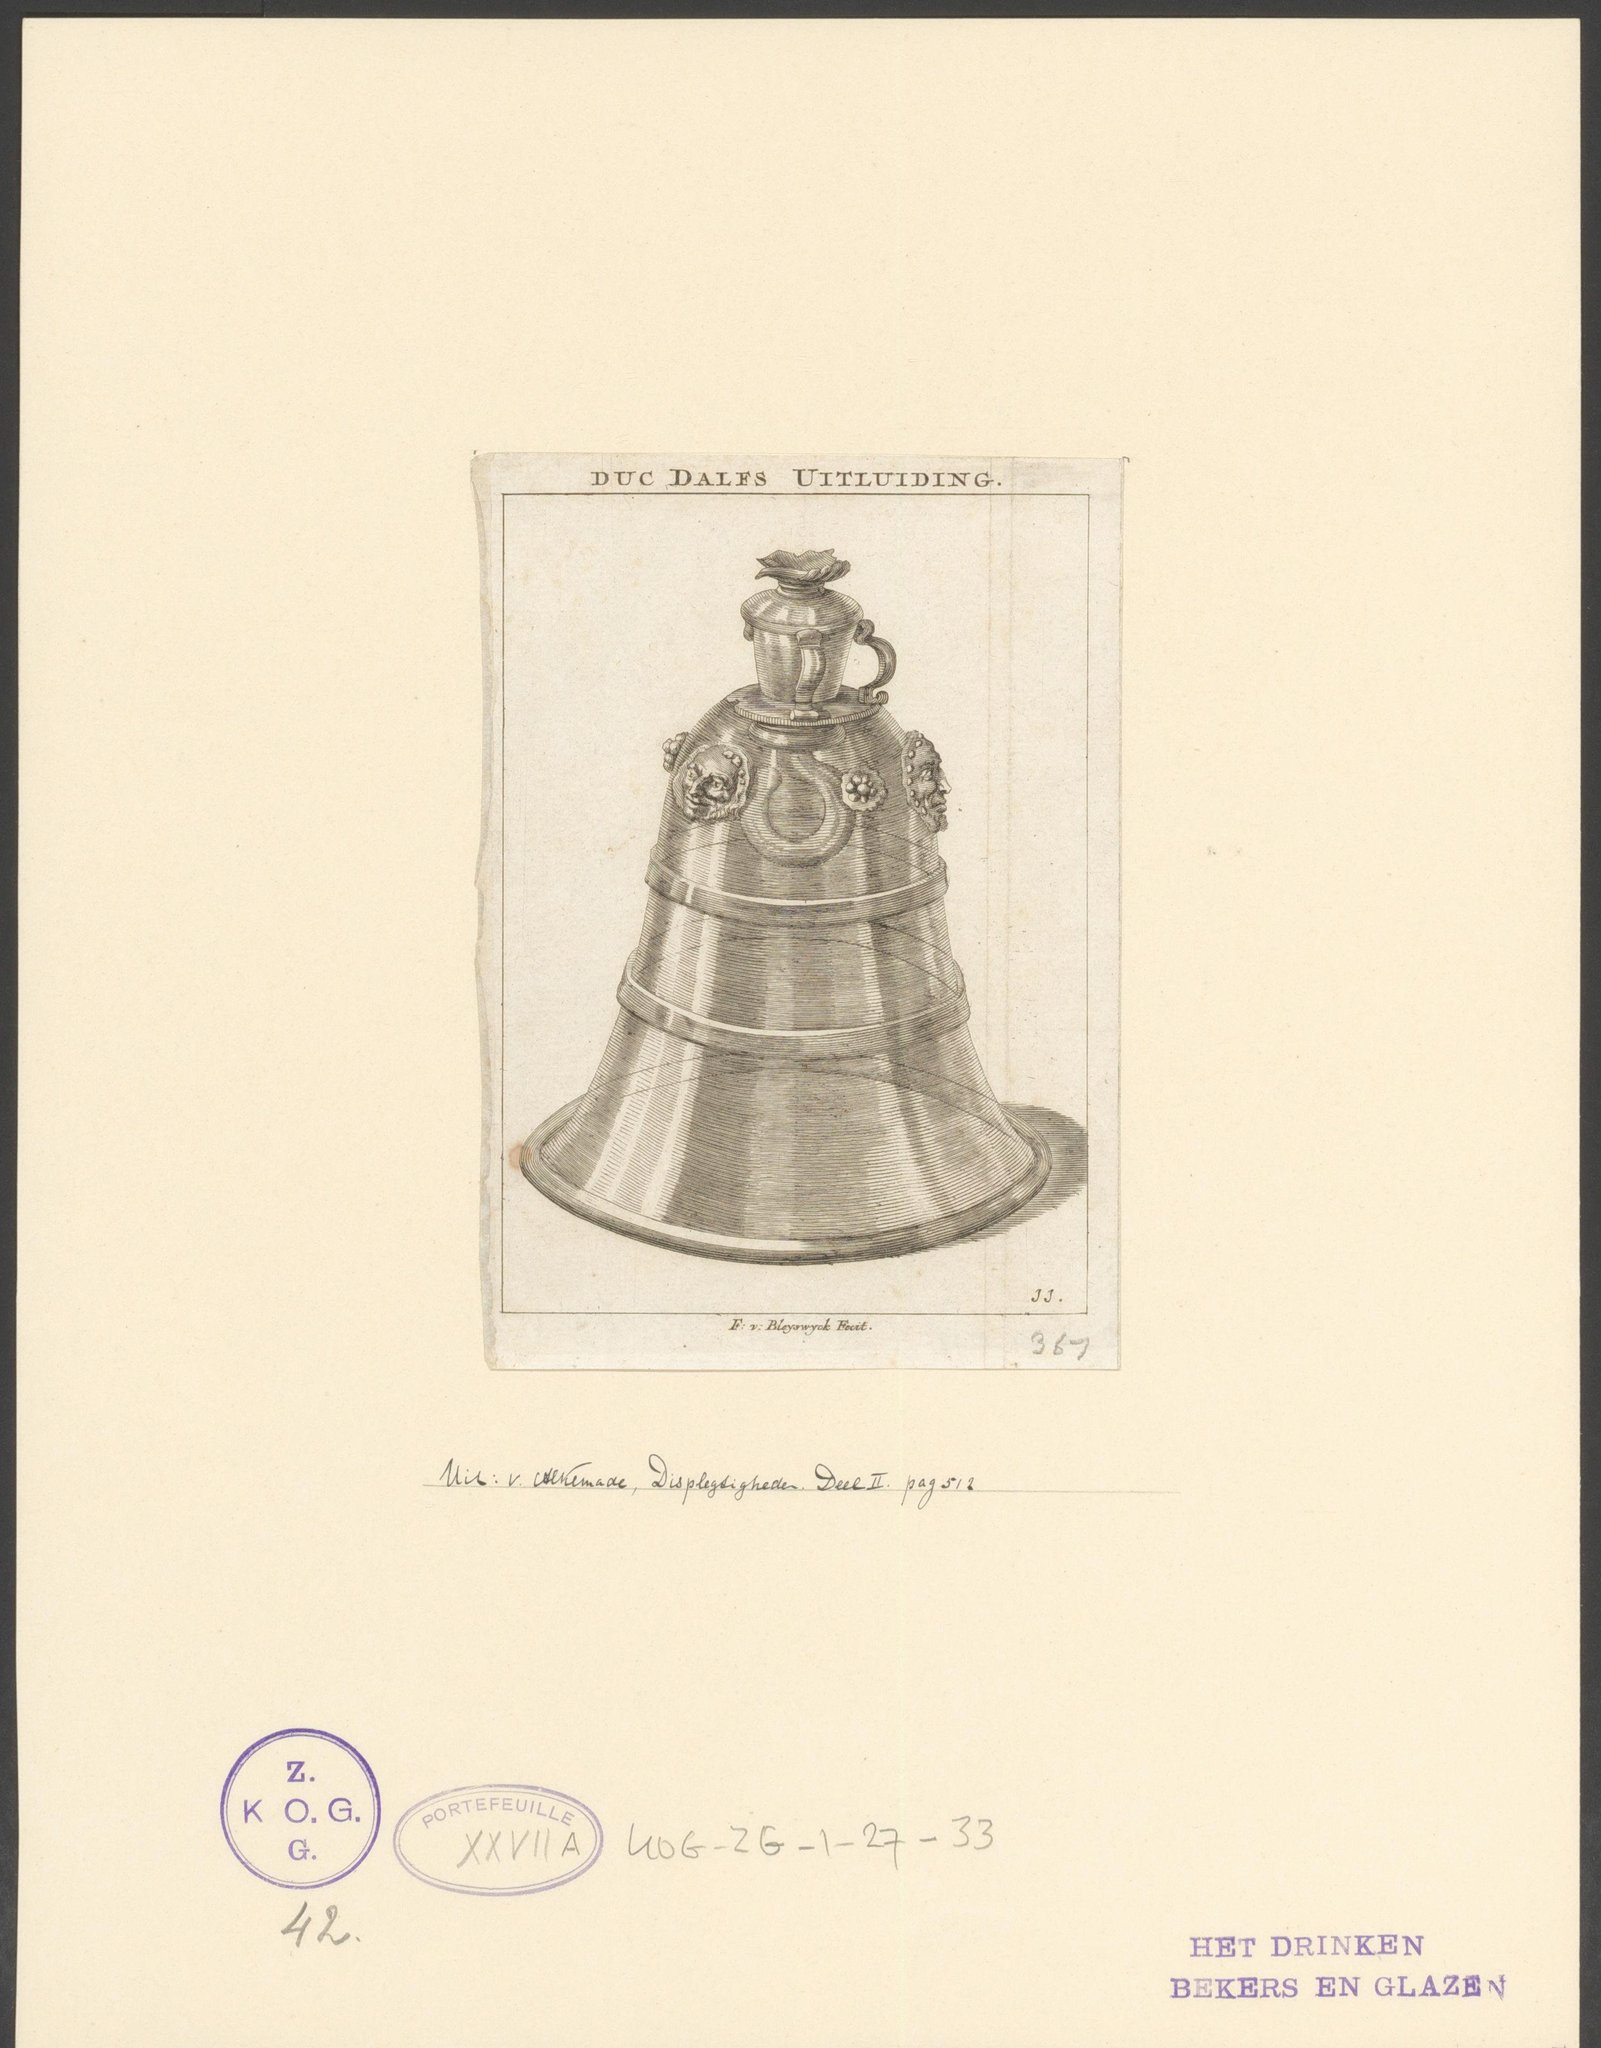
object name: print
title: Duc Dalfs uitluiding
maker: françois van bleyswijck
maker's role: draughtsman, print maker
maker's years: 1671-1746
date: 1732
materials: paper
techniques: etching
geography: netherlands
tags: philip ii of spain, fernando álvarez de toledo (3rd duke of alba), glass, rummer, alcoholic drinks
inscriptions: collector's mark, collector's mark: Lugt 1641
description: Gebruikt als illustratie in: Cornelis van Alkemade en Pieter van der Schelling, Nederlands displegtigheden. Rotterdam: Philippus Losel, 3 dln. 1732-1735, dl. II (1732), t.o. p. 512.